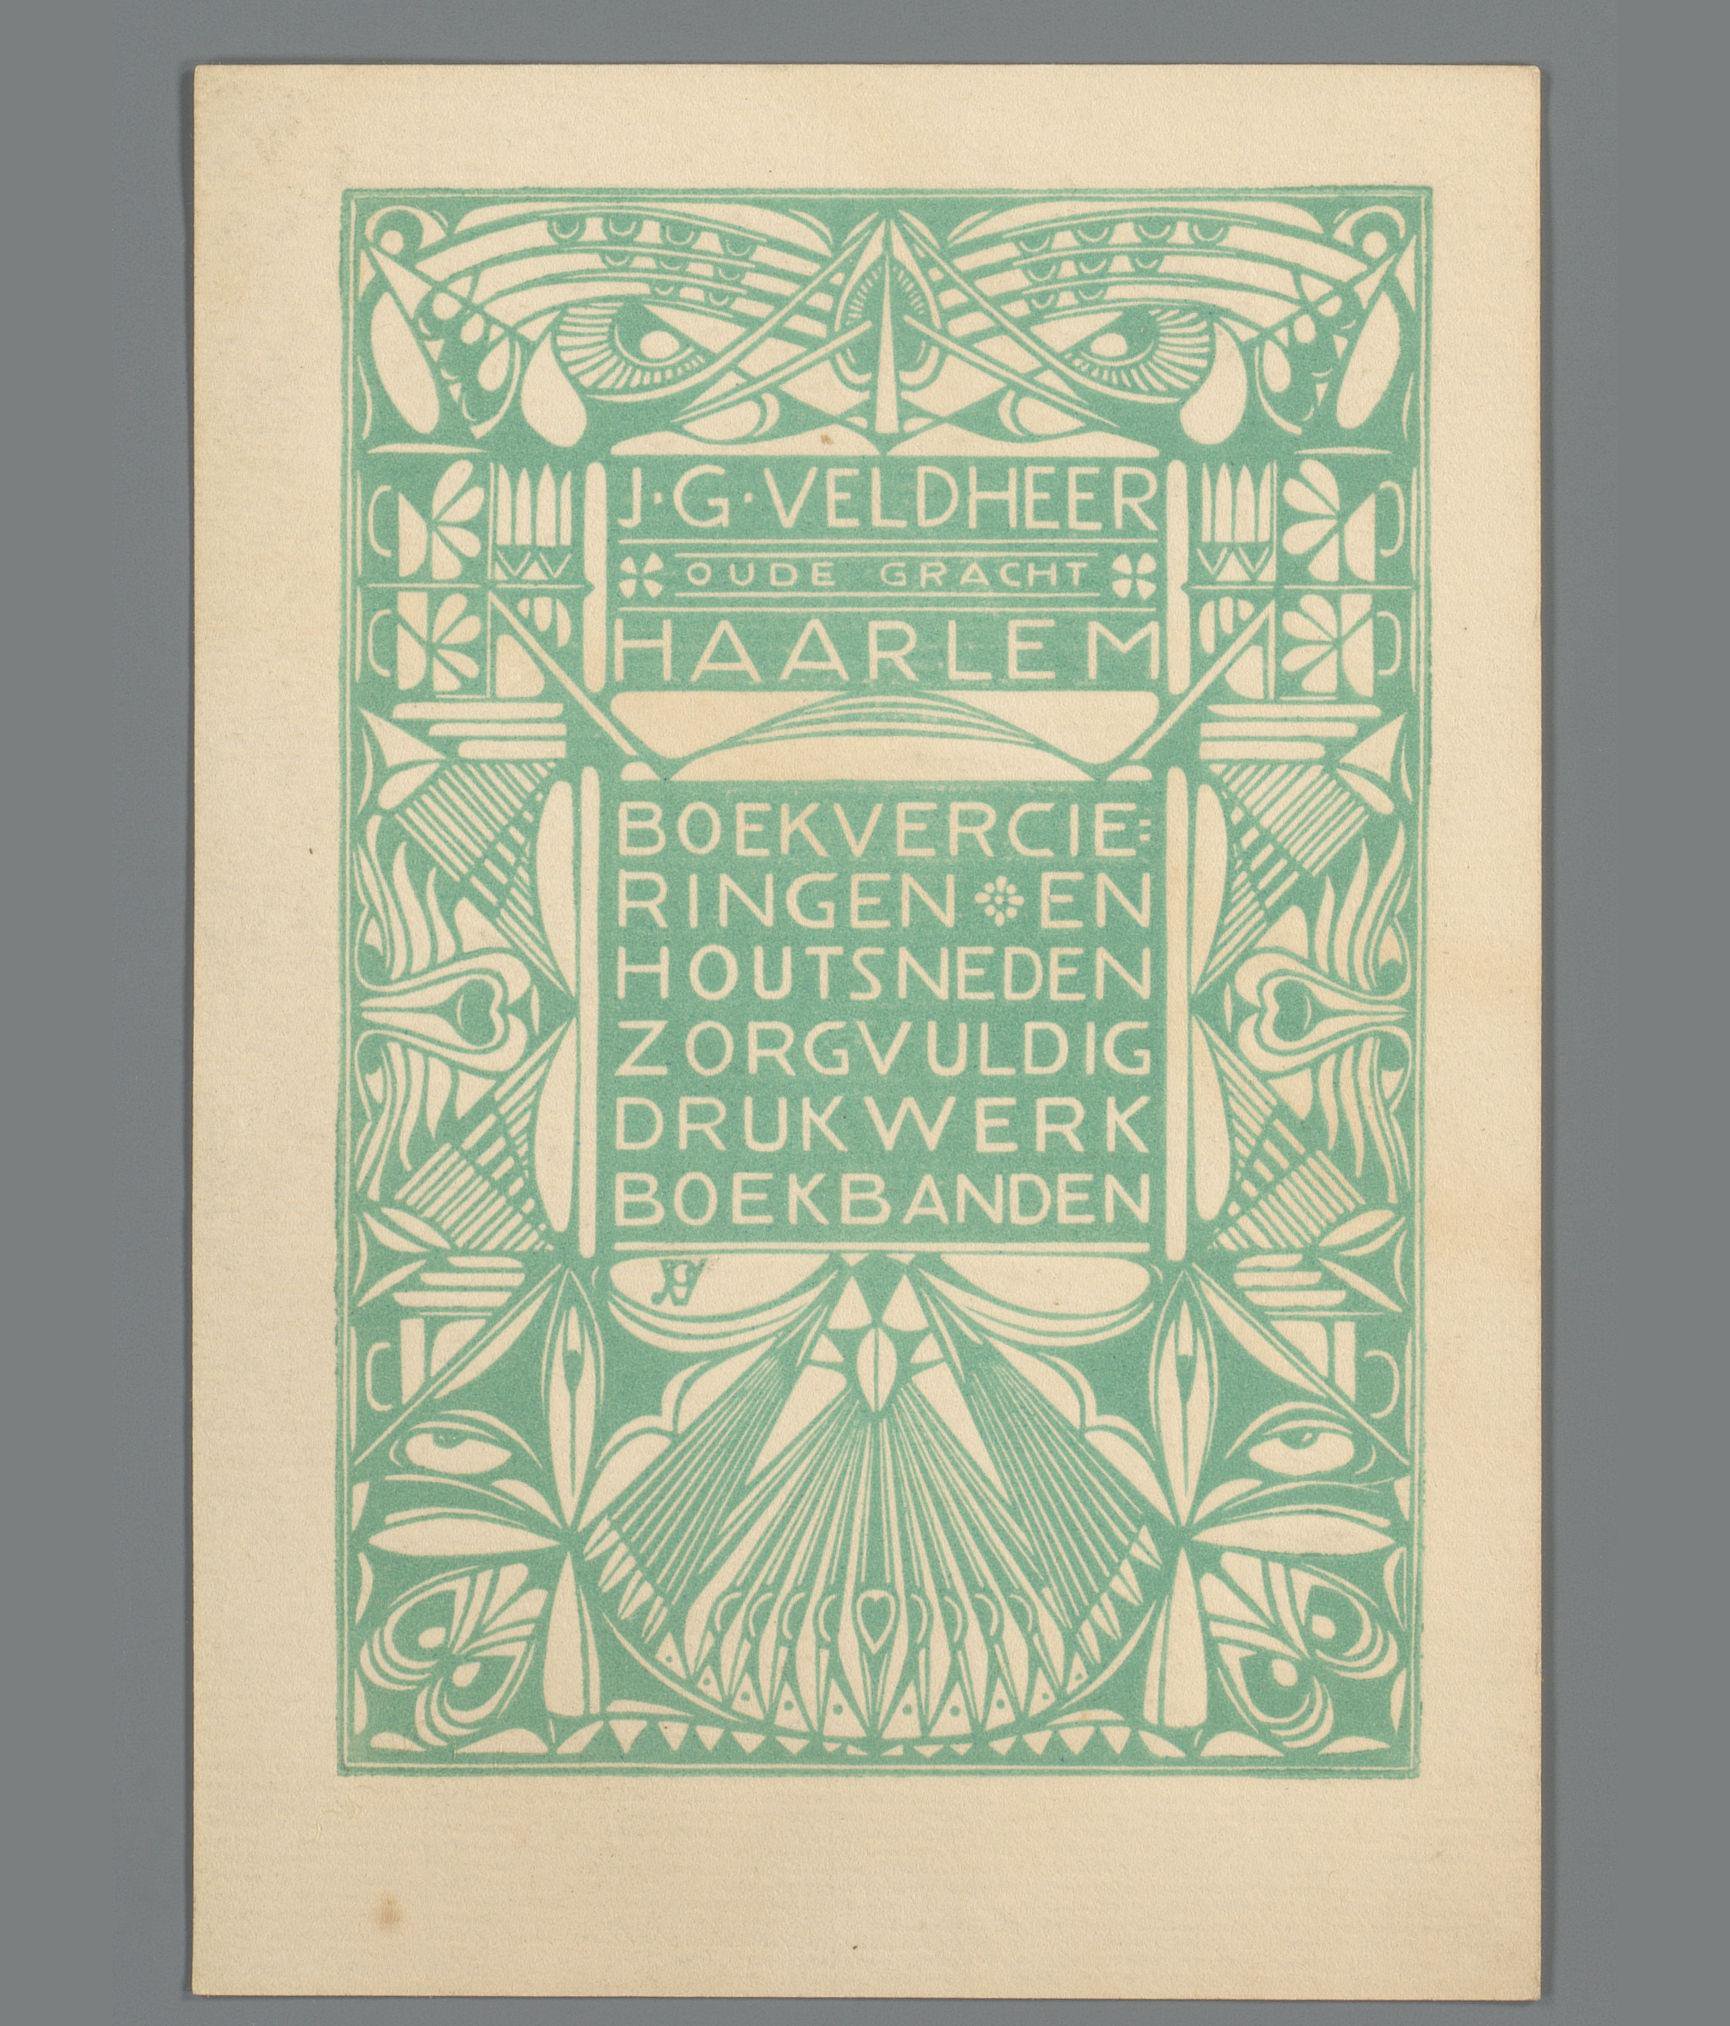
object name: visiting card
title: Visitekaart van Jaap Veldheer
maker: jacobus gerardus veldheer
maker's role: draughtsman, print maker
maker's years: 1866-1954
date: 1876-1954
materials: paper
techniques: woodcut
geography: haarlem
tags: haarlem, print maker, draughtsman, jacobus gerardus veldheer, ornaments ~ art, visiting-card, calling-card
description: Een decoratief kader met in het midden: 'J.G. Veldheer. Oude Gracht, Haarlem. Boekvercieringen en houtsneden, zorgvuldig drukwerk, boekbanden'.